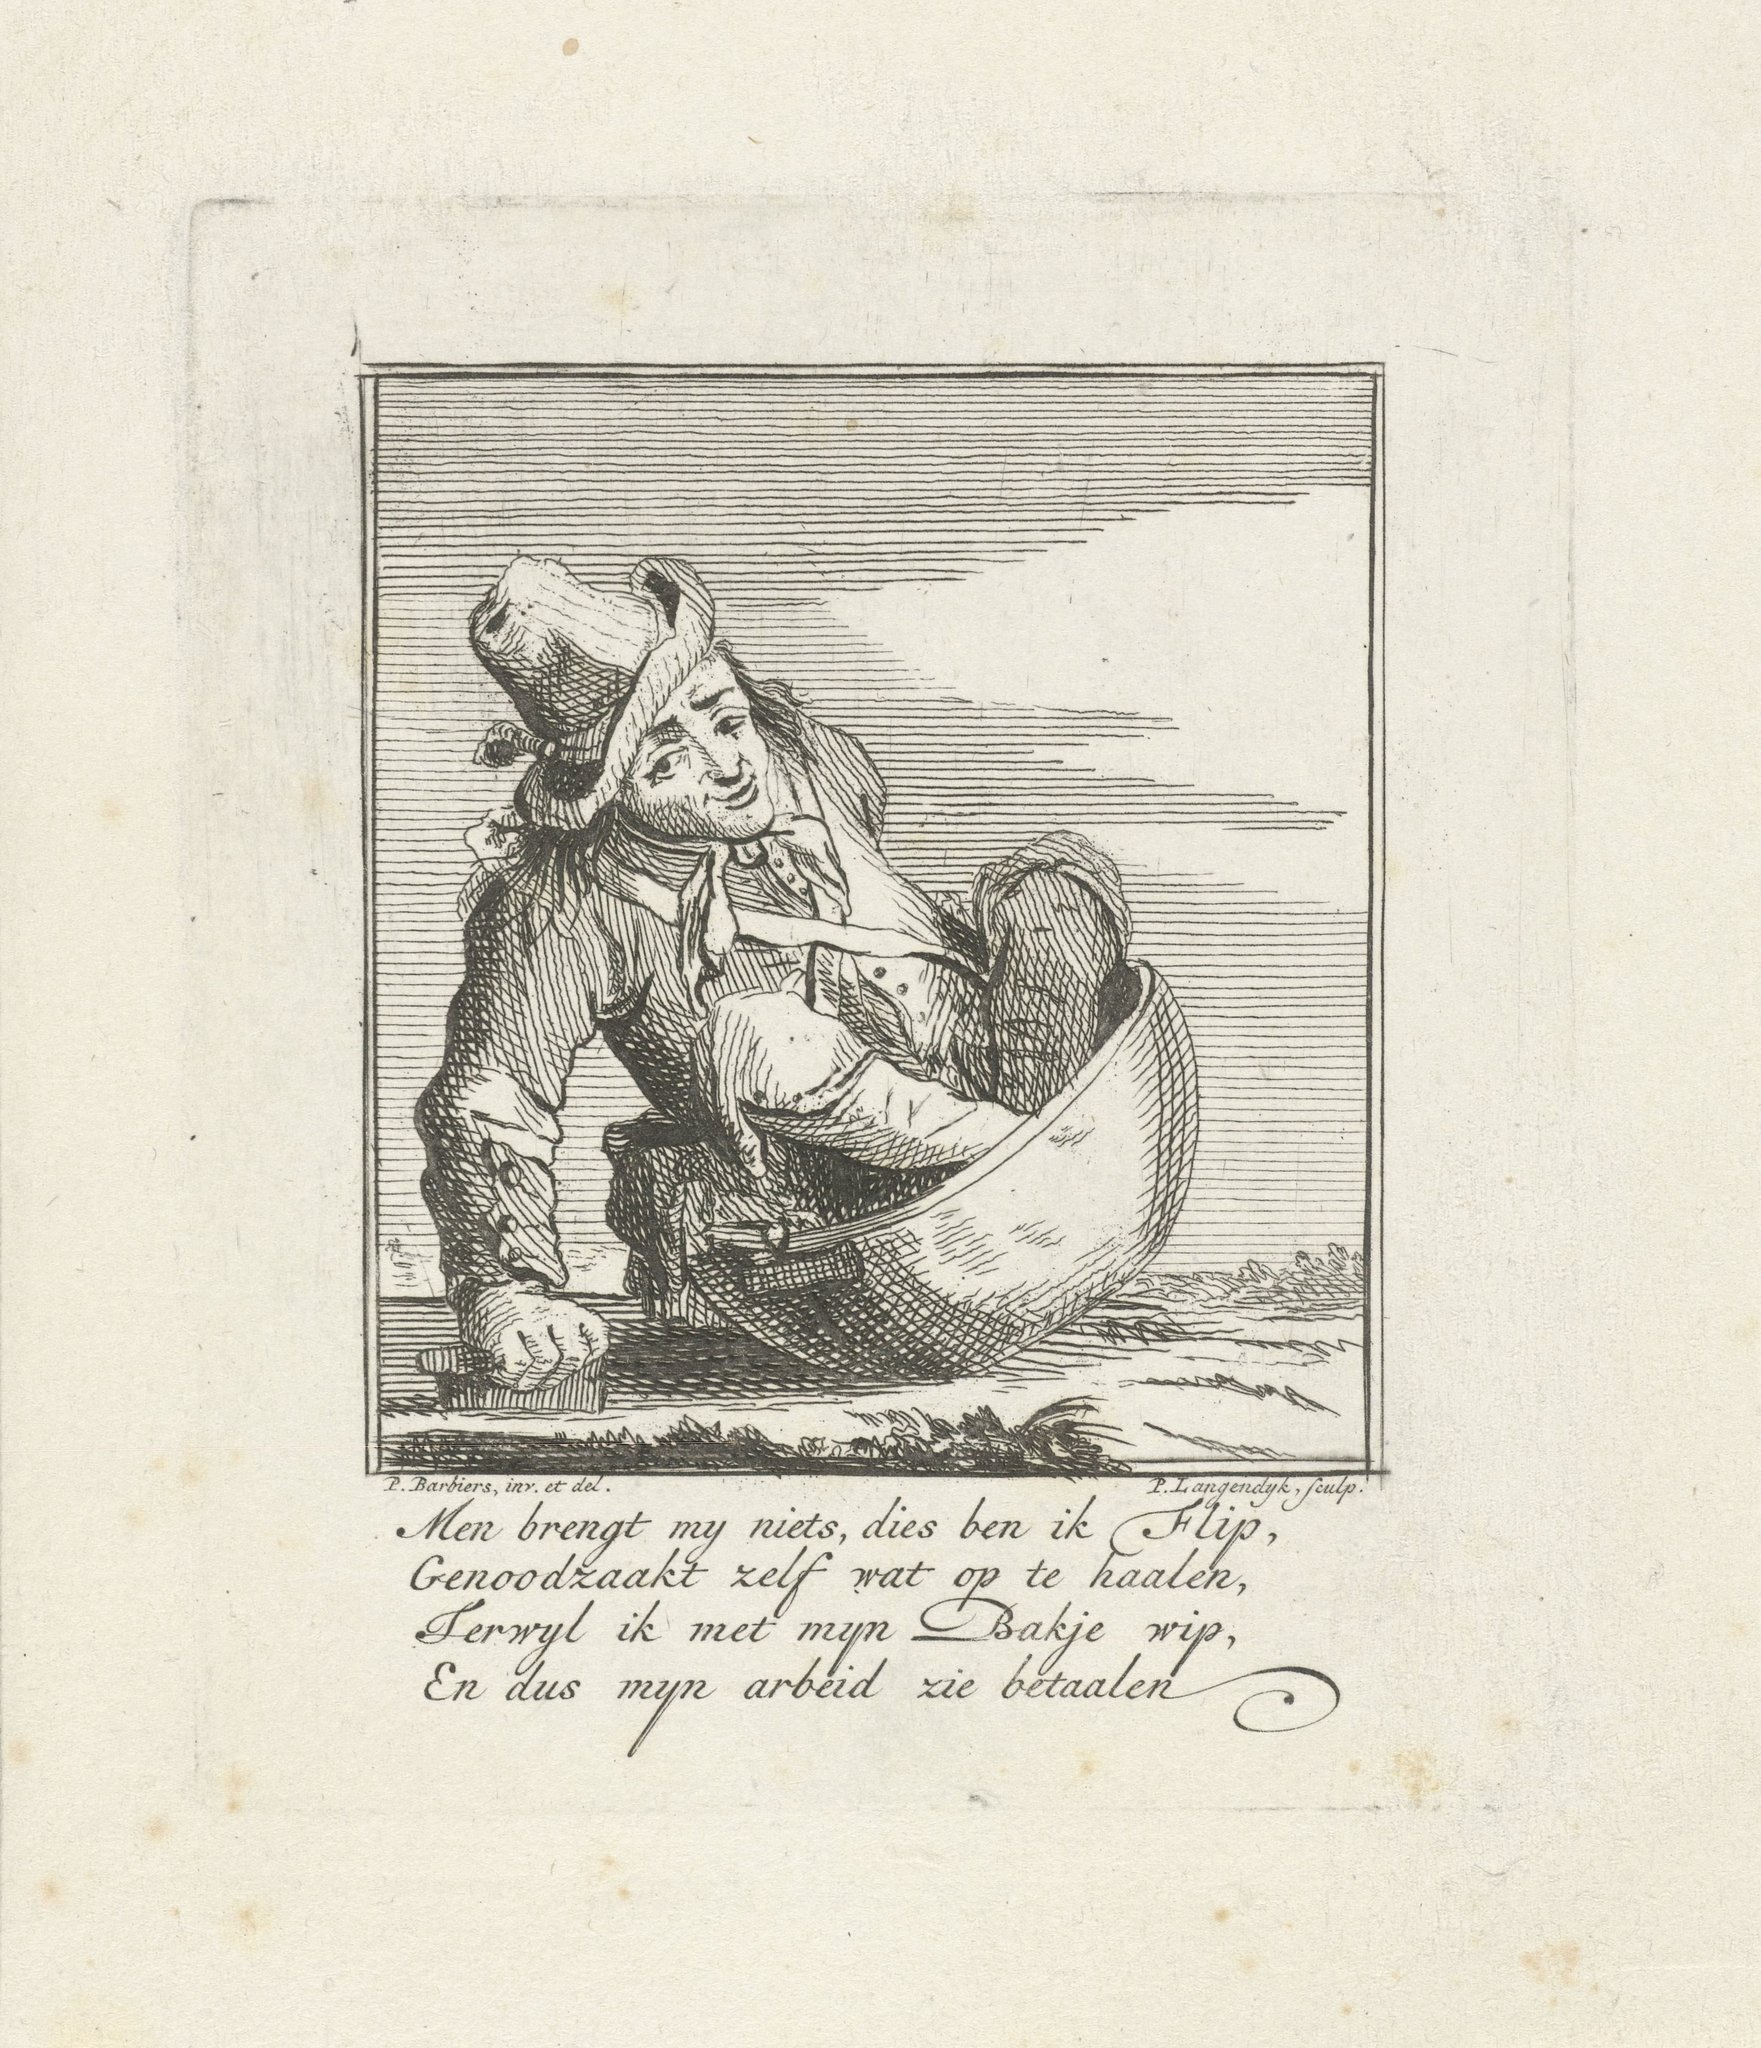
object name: print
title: Amsterdamse straatfiguren rond 1770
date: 1770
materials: paper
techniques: engraving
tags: person with a physical disability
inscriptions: collector's mark: Lugt 240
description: Een kreupele man beweegt zich voort in een rond bakje. In de marge een vierregelig vers in het Nederlands. Onderdeel van een serie van prenten van Amsterdamse straatfiguren rond 1770.